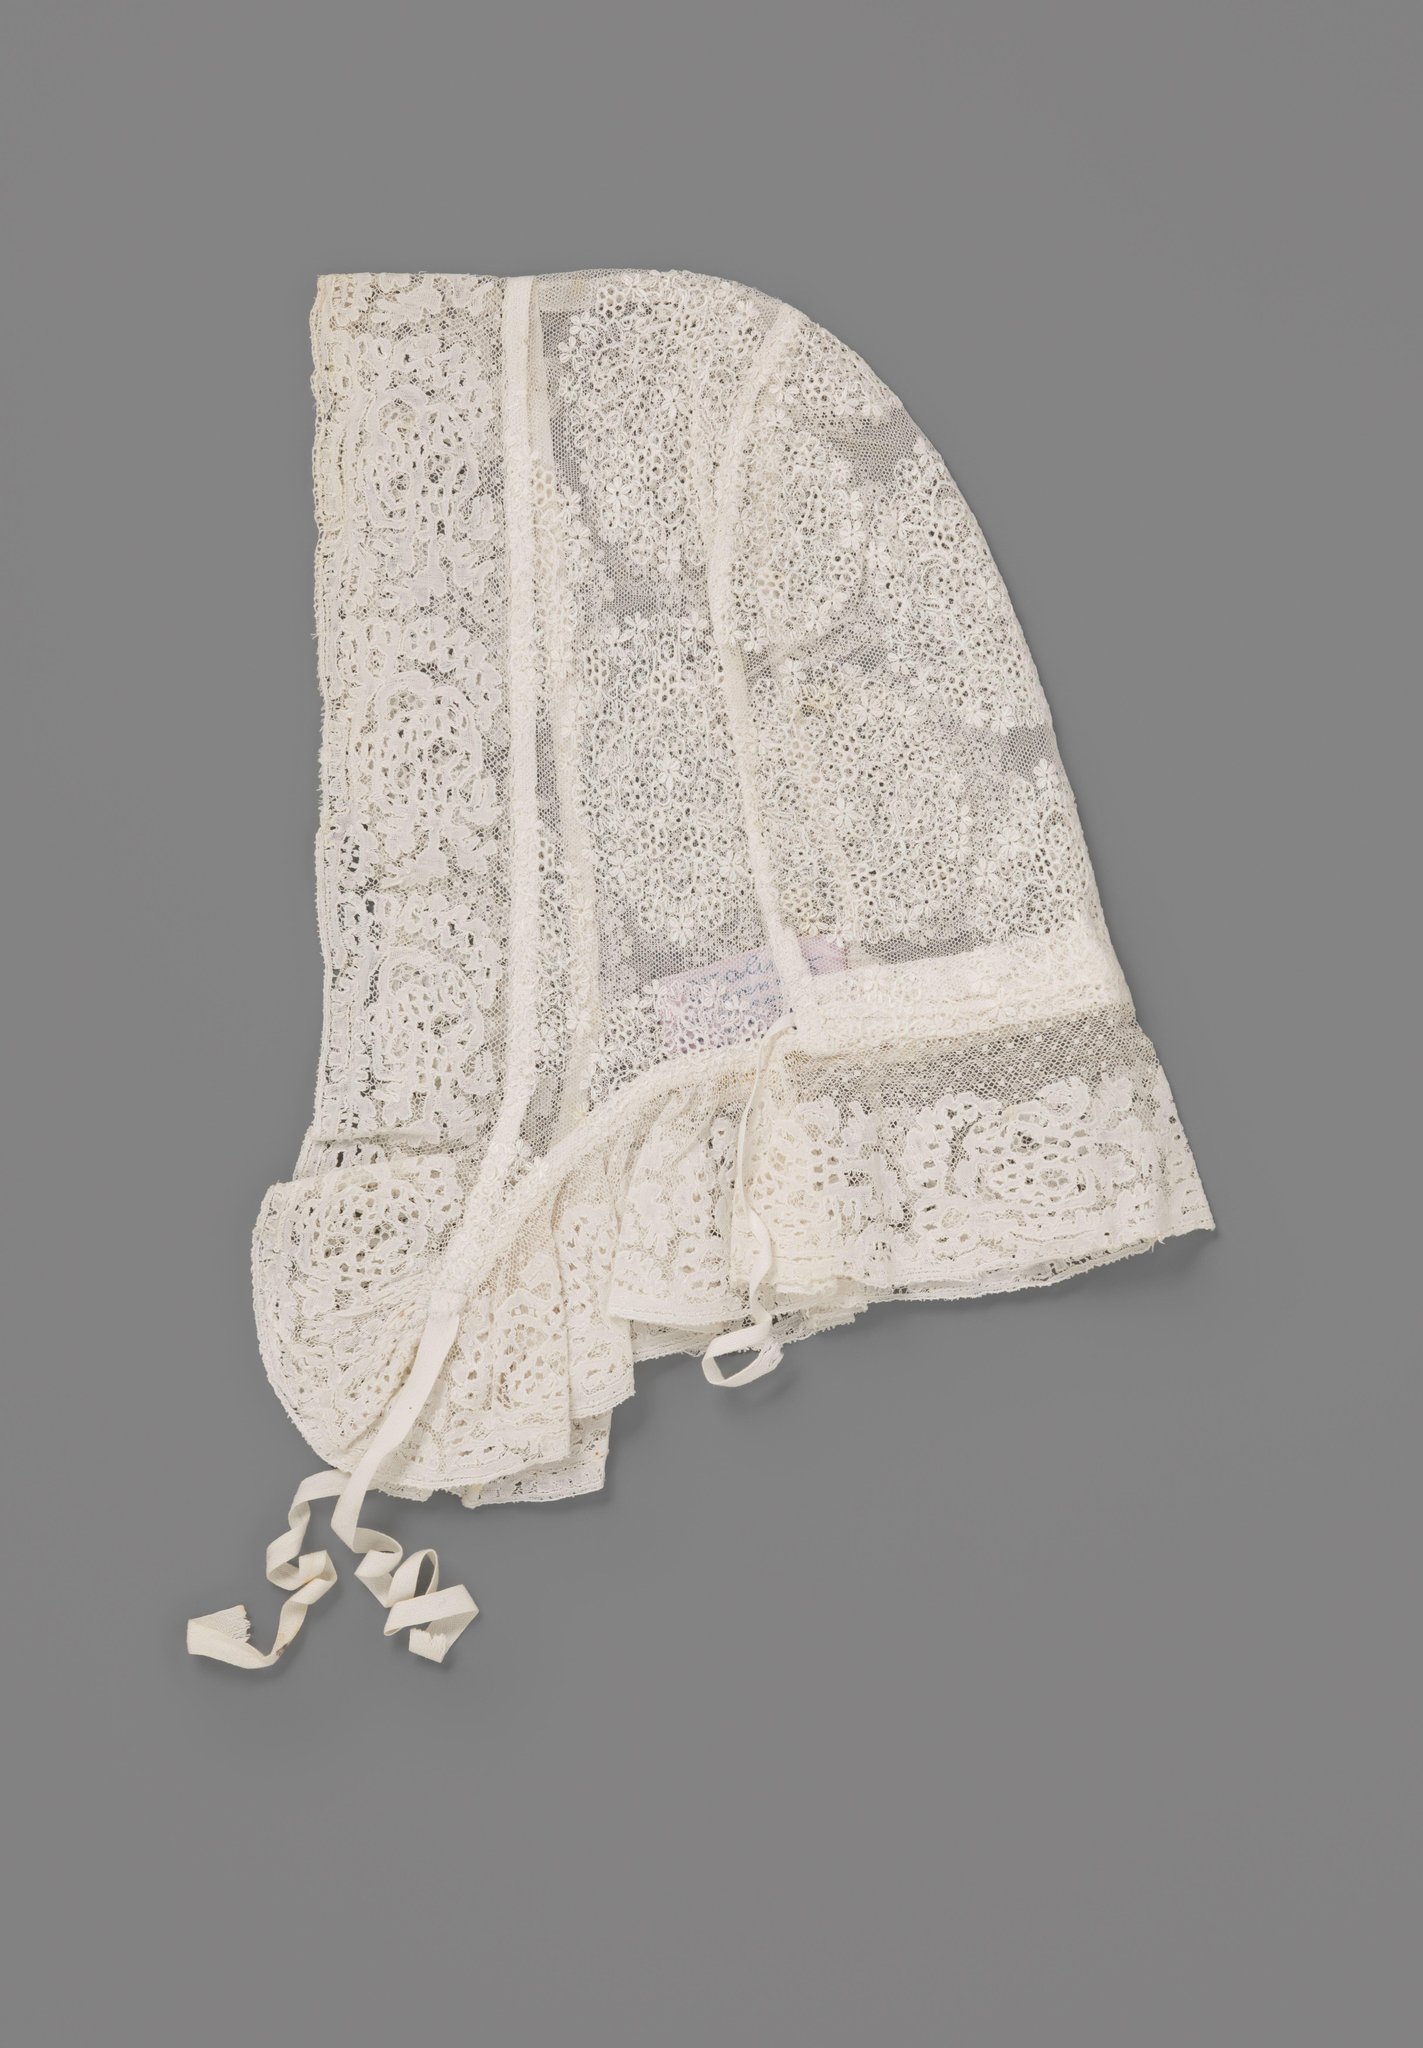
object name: womenswear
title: Muts met Fries kantwerk (doorstopwerk) en Rijsselse (?) kant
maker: Anonymous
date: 1850-1900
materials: lace, fiber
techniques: lace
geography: western europe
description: Muts met Fries kantwerk (doorstopwerk) met een gerimpelde strook Rijsselse kant. Over de muts lopen twee tunnels voor rijgkoorden.